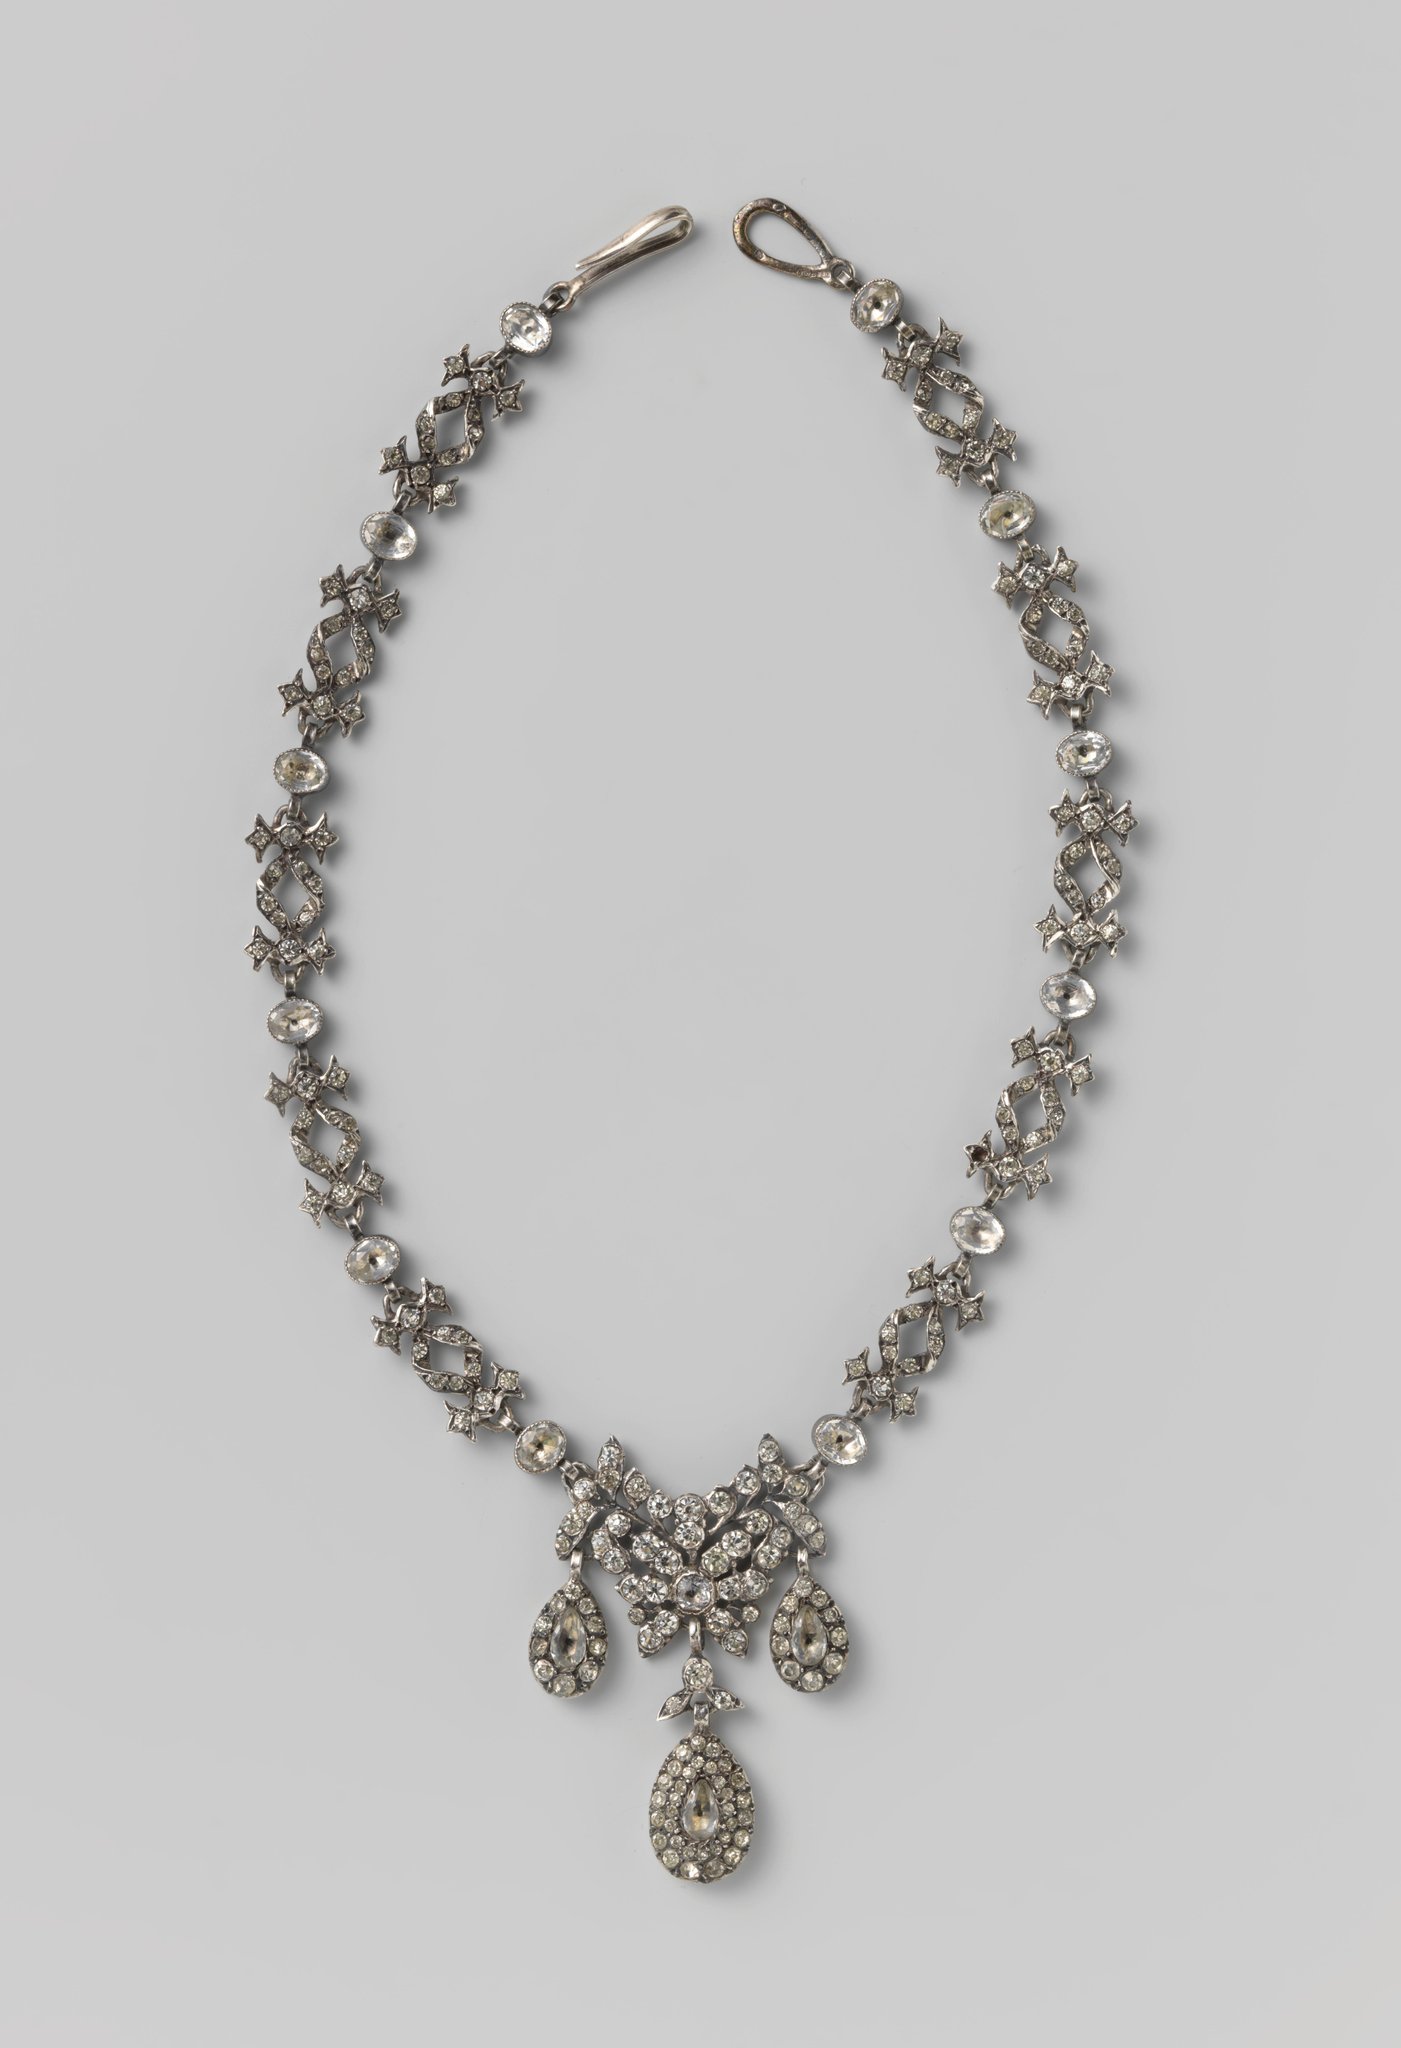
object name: jewellery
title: Halsketting van zilver met stras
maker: Anonymous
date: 1770-1790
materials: paste, silver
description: Halsketting van zilver met stras. Op een met hanger verbrede schakelband van zilver zijn 12 grote ovale, 1 grote ronde en 3 peervormige strasz diamanten gevat. De hanger heeft een vlindervormig midden bekroond met een bladtak met drie afhangende druppels.